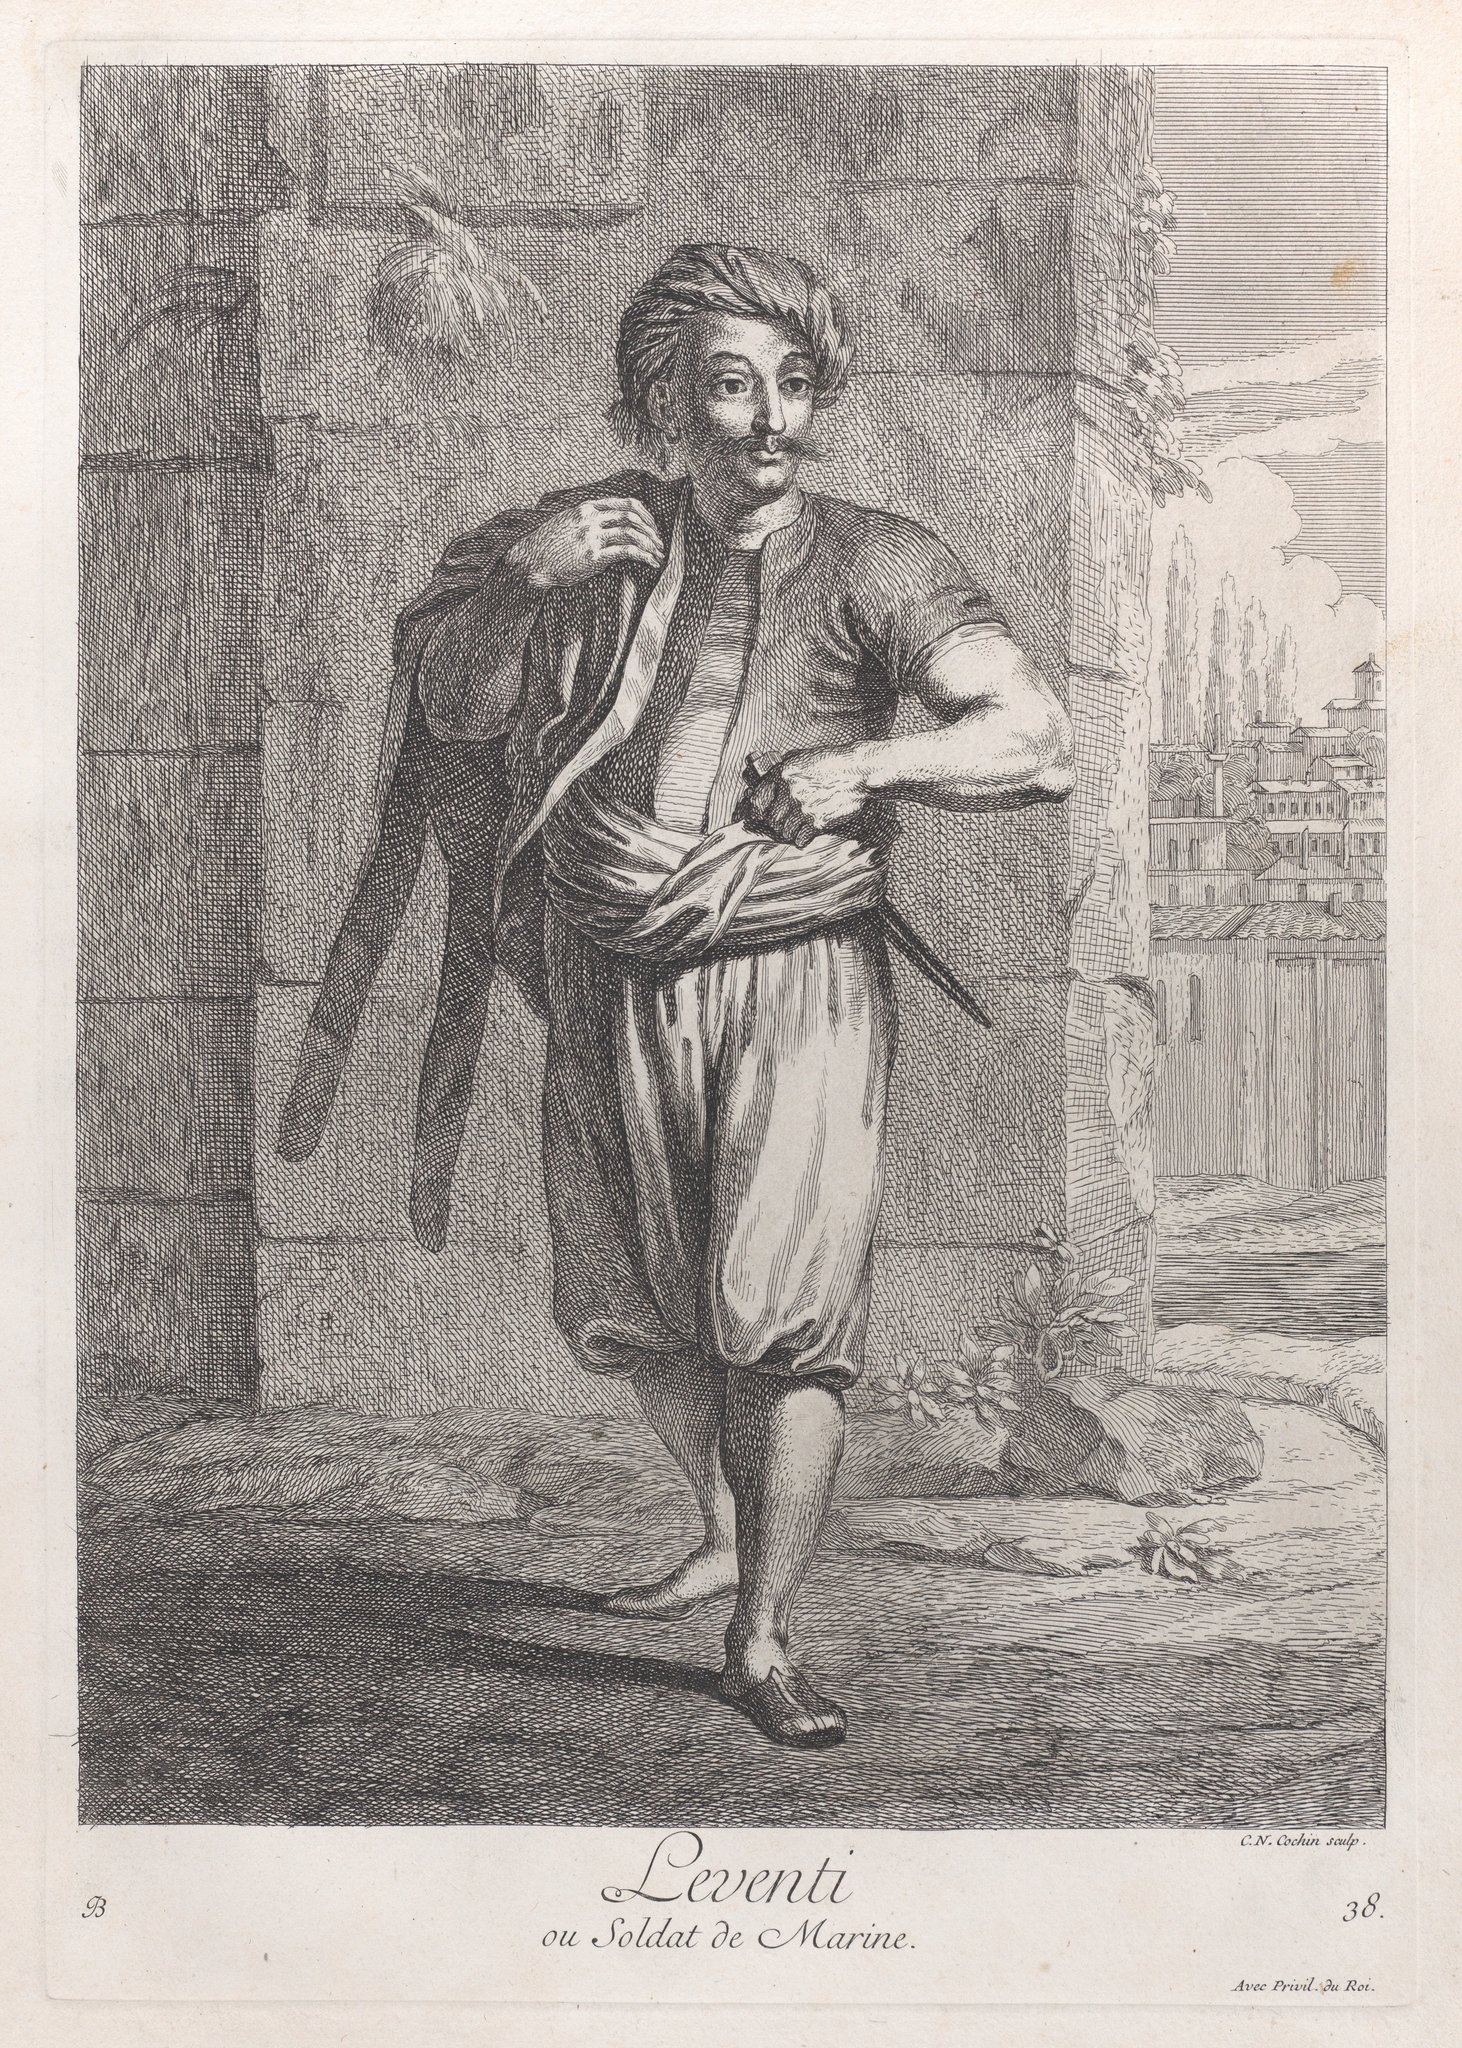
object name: print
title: Leventi, ou Soldat de Marine, plate 38 from "Recueil de cent estampes représentent differentes nations du Levant"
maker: jean baptiste vanmour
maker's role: artist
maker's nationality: french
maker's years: 1671-1737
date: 1714-1715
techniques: engraving, etching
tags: men